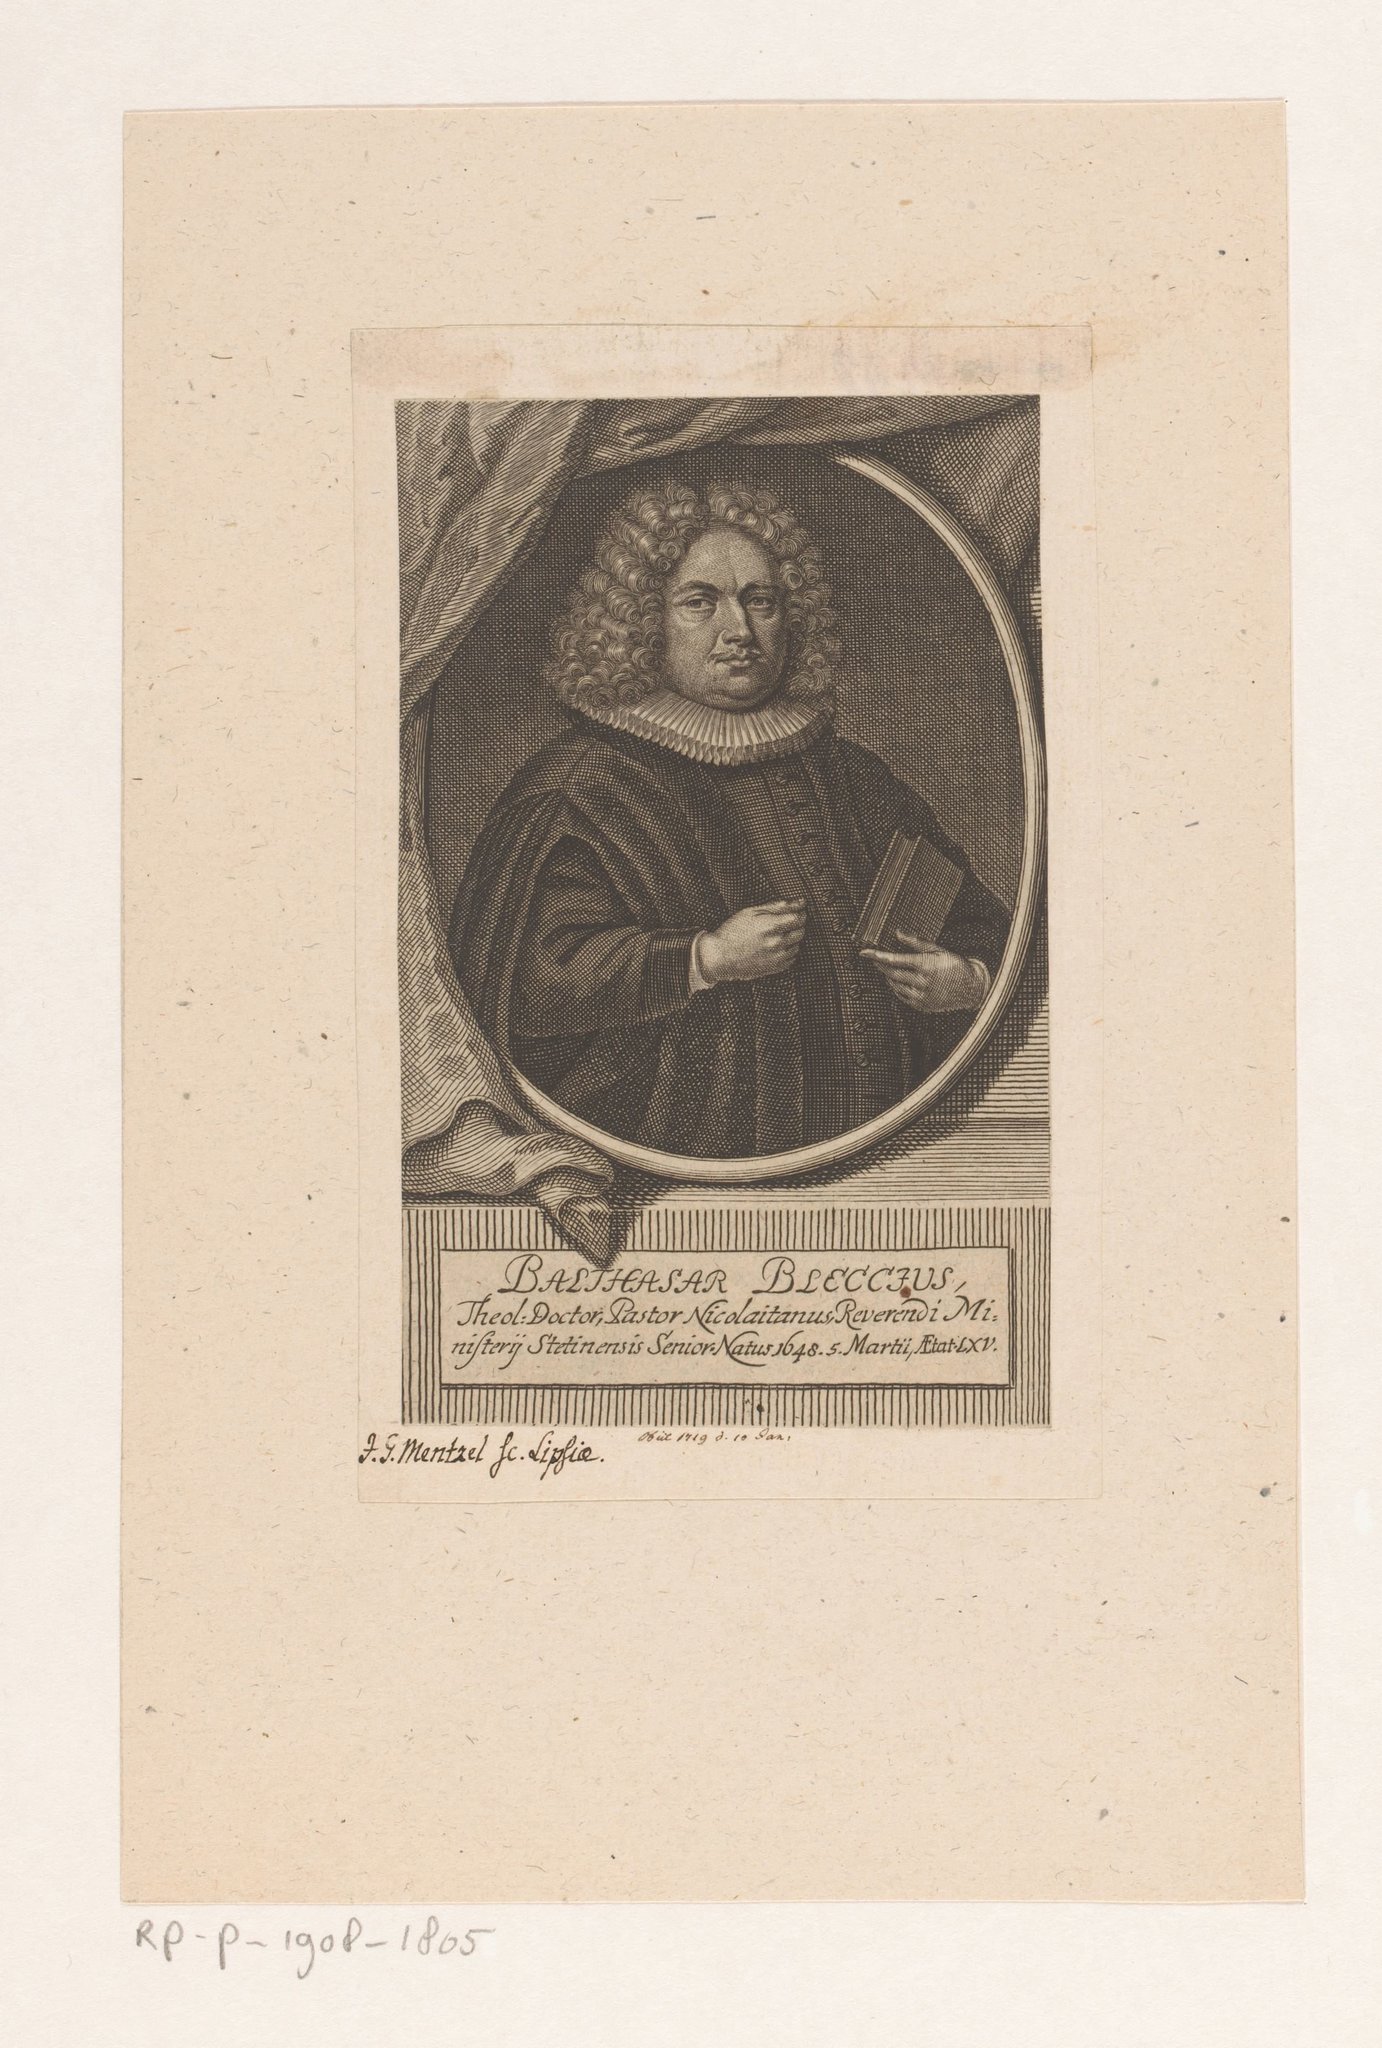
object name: print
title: Portret van Balthasar Blecchius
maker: johann georg mentzel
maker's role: print maker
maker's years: 1677-1743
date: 1687-1743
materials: paper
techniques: engraving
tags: theologian, historical persons, book, wig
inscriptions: collector's mark: Lugt 2228